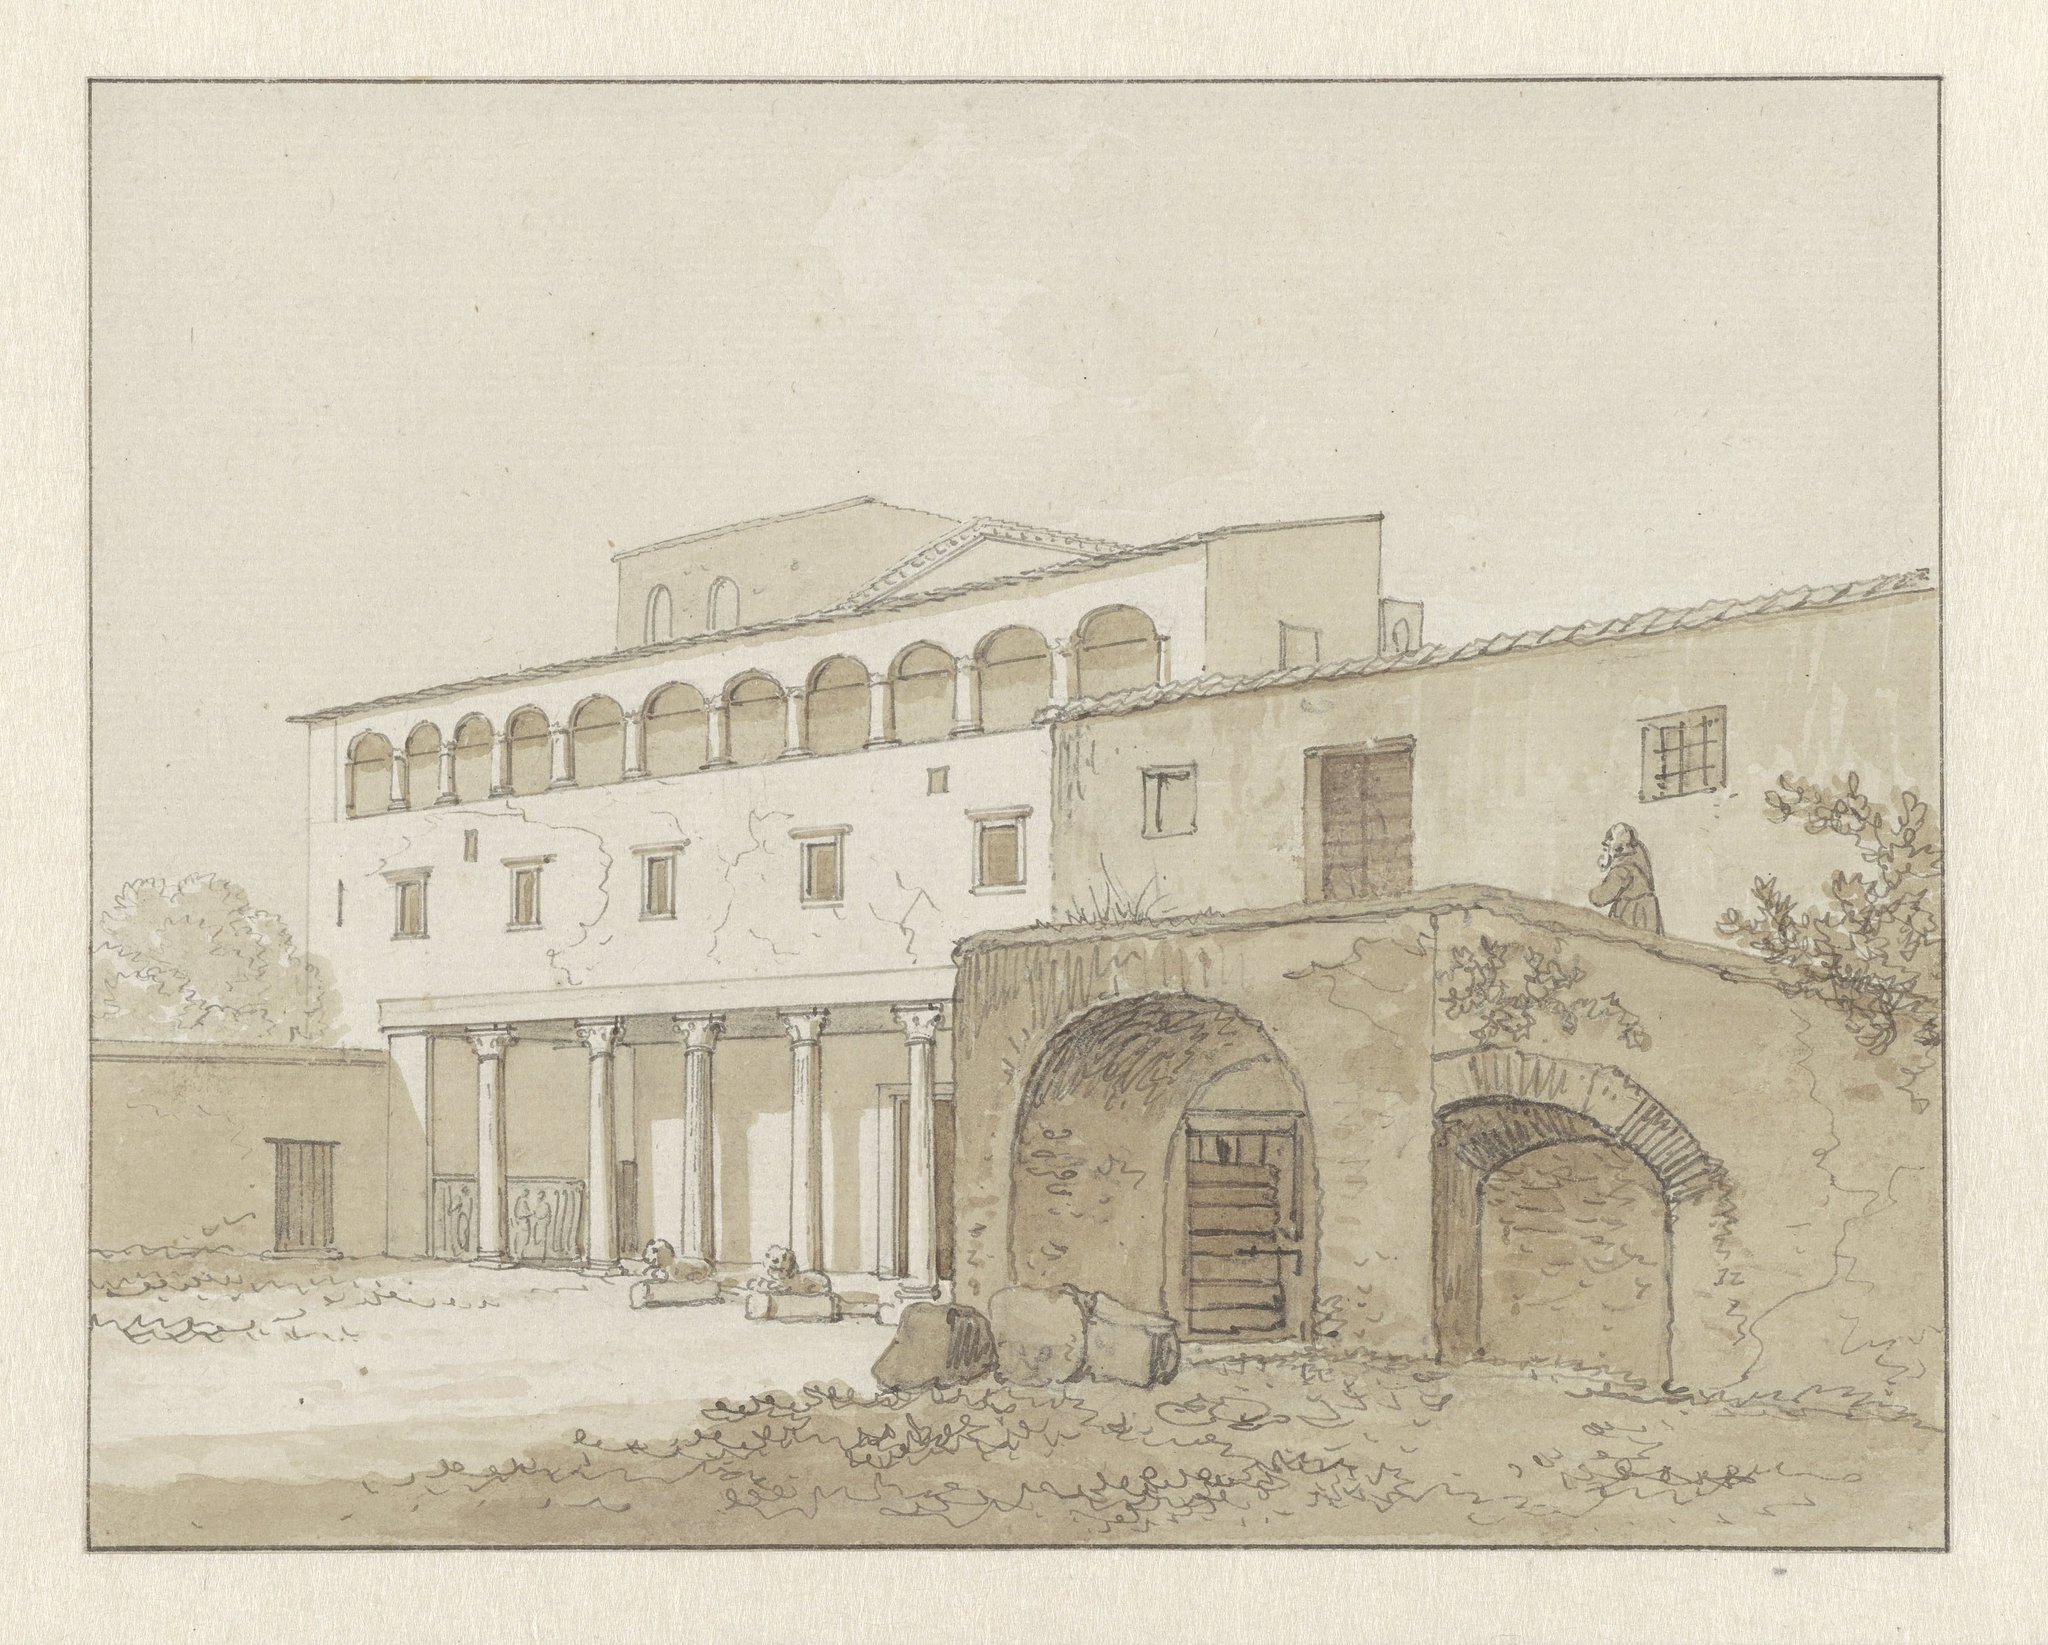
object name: drawing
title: Gezicht op de Aventijn in Rome, met de kerk van S. Saba, Abbate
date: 1761-1817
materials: chalk, ink, paper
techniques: brush, pen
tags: church (exterior), rome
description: Tekening uit een groep tekeningen van landschappen en stadsgezichten in Italië (Rome, Tivoli, Civita Castellana en Pozzuoli).